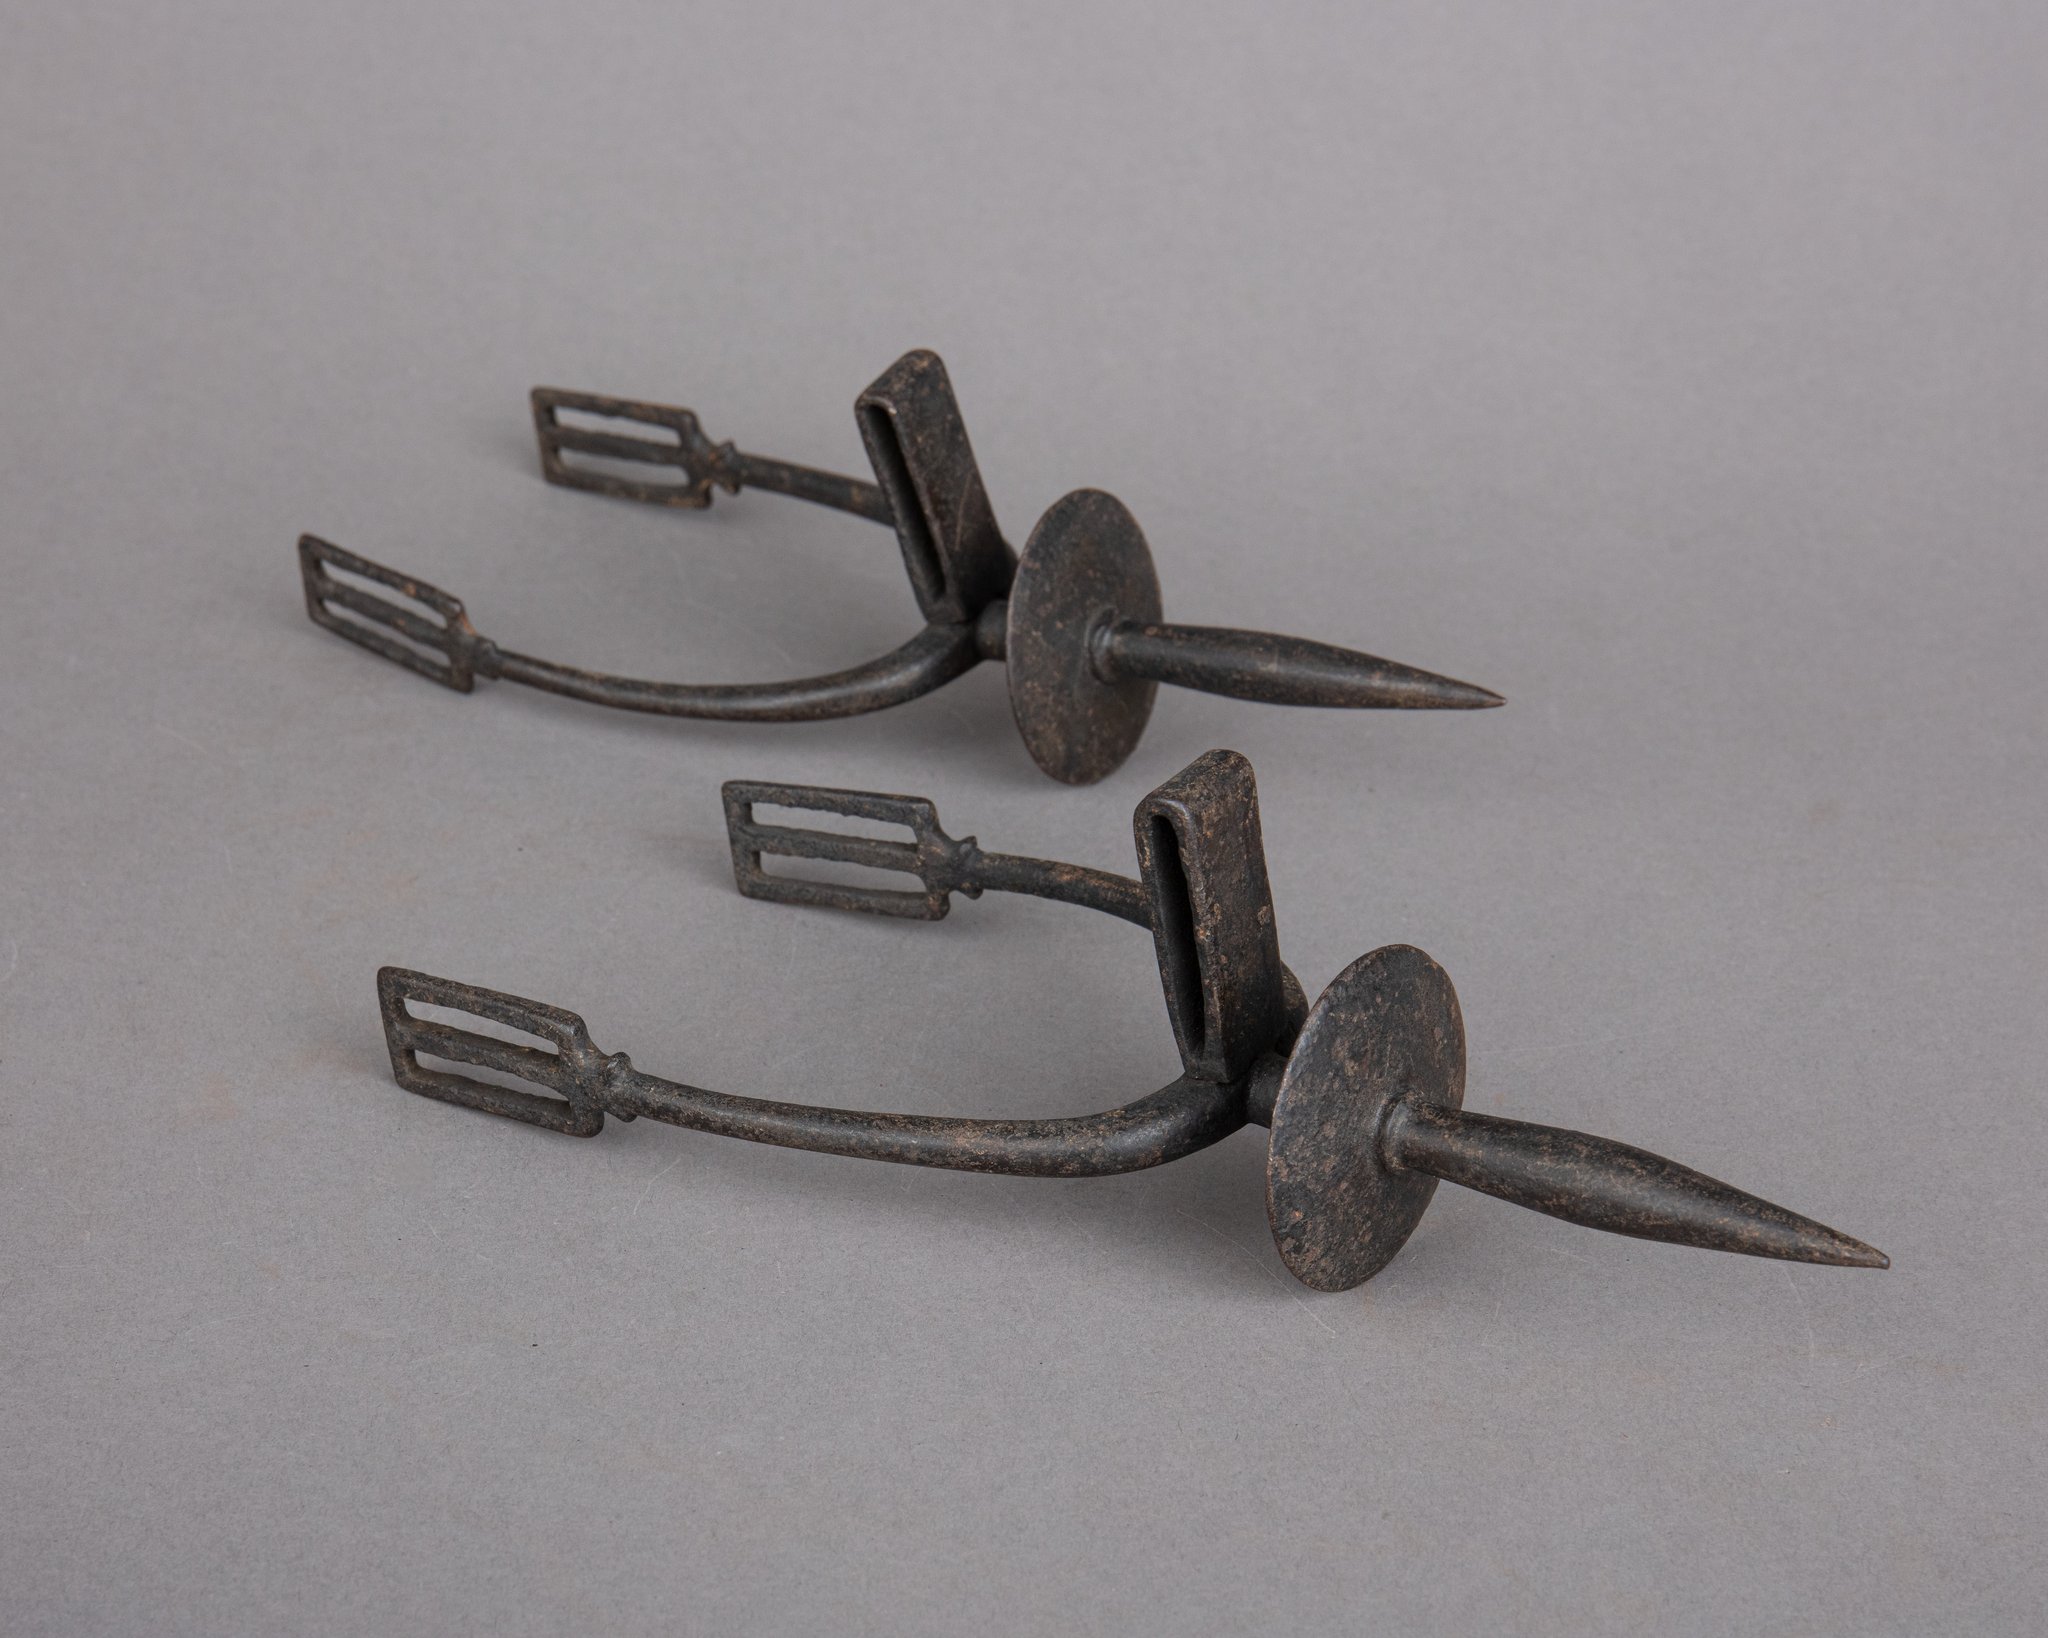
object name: spur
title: Pair of Prick Spurs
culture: north african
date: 1801-1900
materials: gold, metal alloy